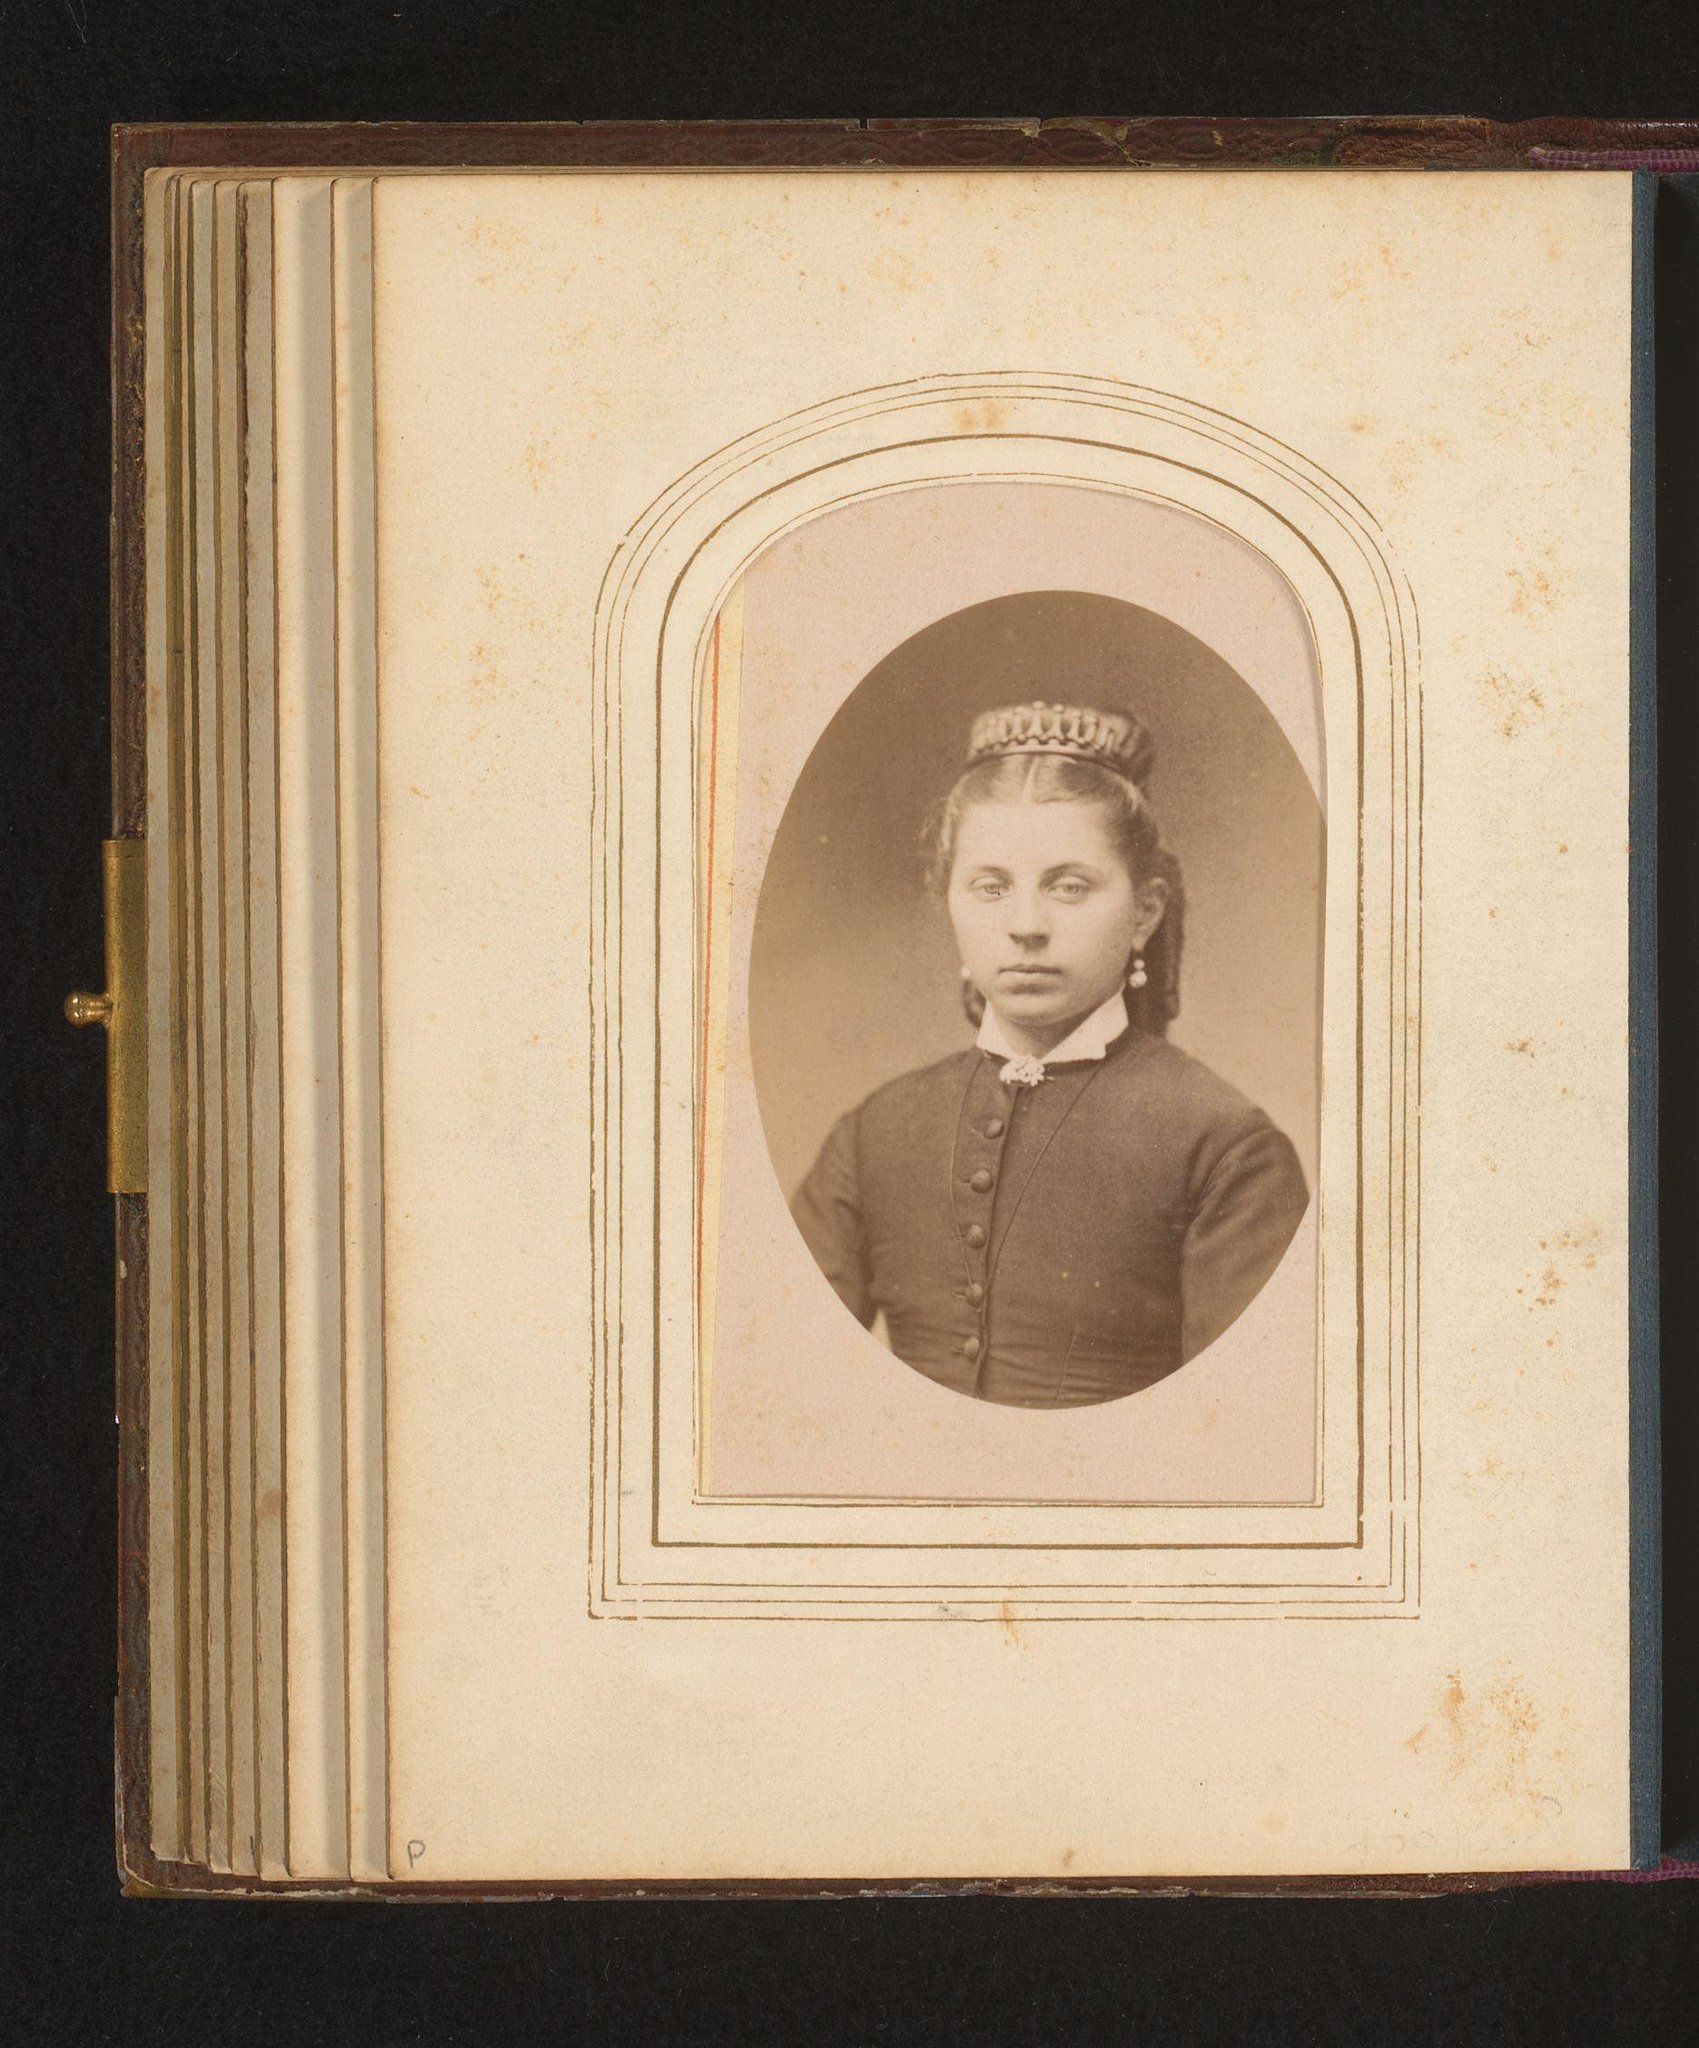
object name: photograph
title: Portret van een jonge vrouw met hoofddeksel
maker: Anonymous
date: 1860-1900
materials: cardboard, photographic support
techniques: albumen print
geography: netherlands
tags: adolescent, young woman, maiden, head-gear, historical persons - bb - woman